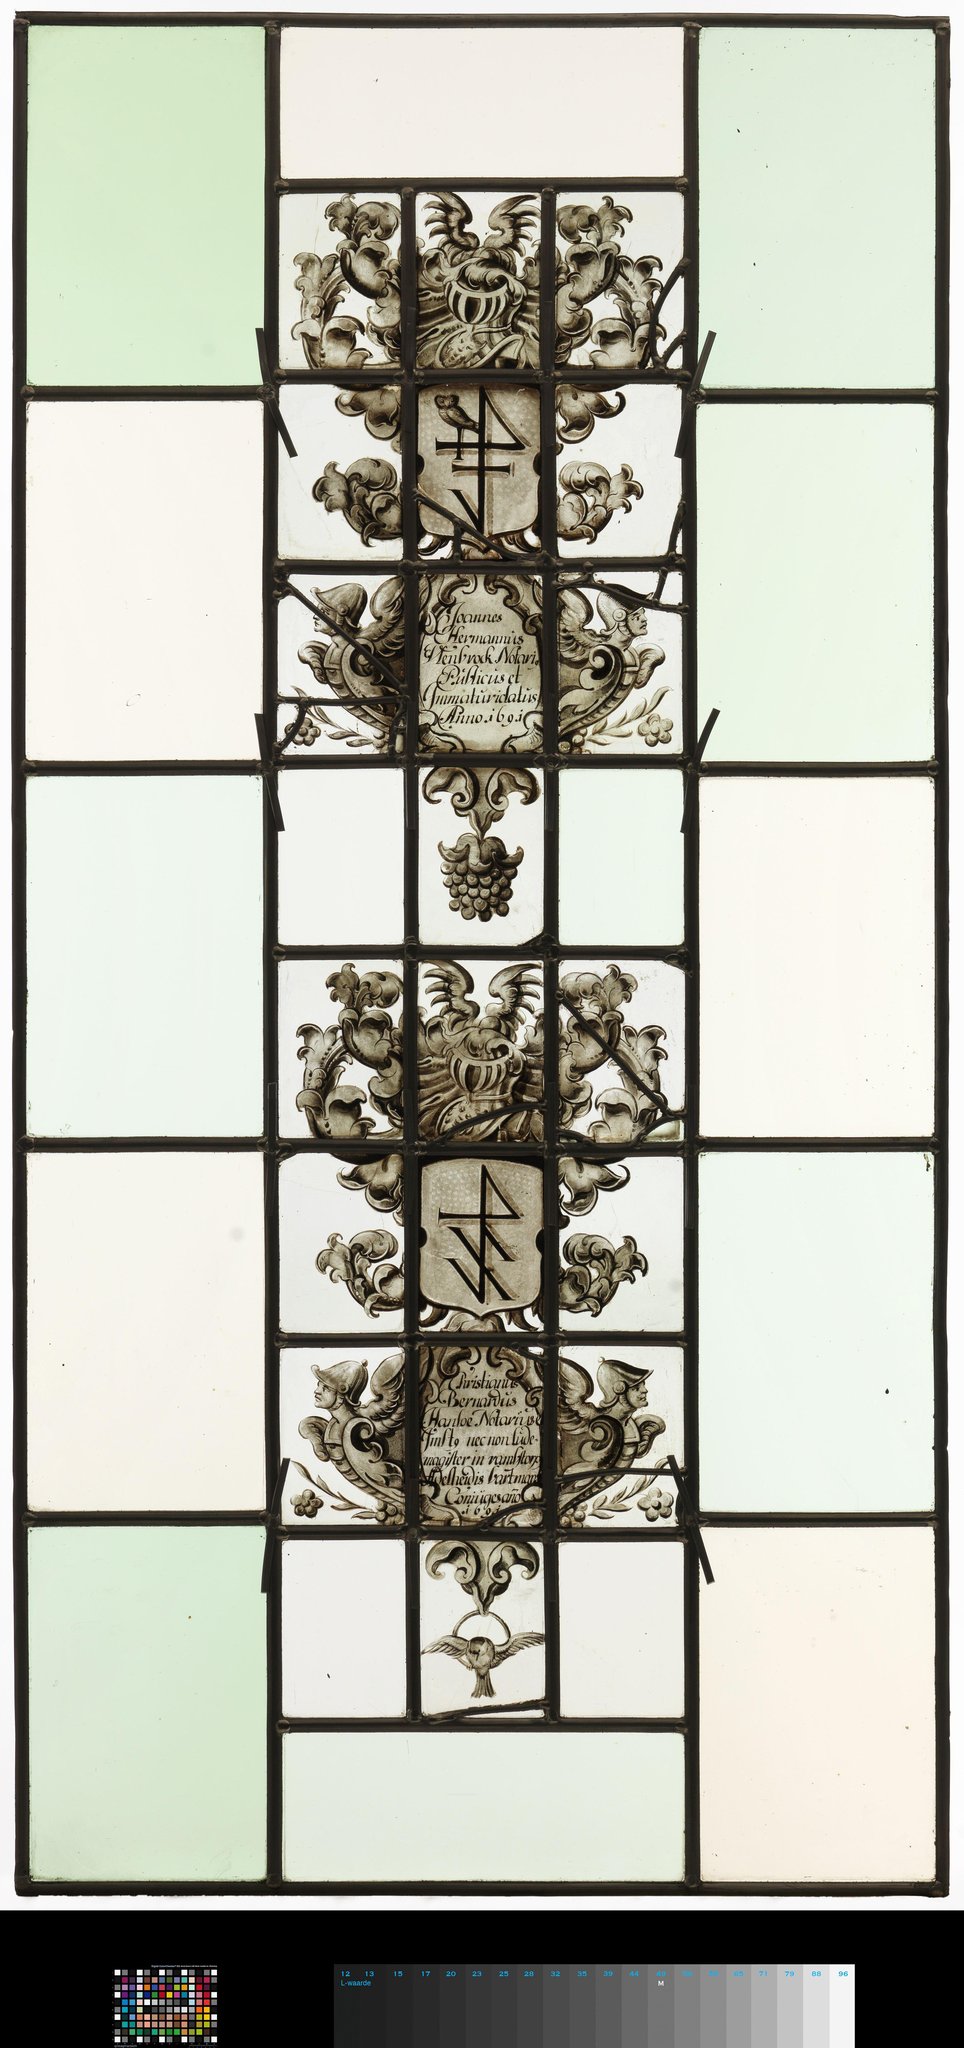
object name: light window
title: Ruit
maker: Anonymous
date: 1699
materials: glass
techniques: enamel painting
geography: westphalia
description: Ruit met gebrandschilderde voorstelling, zit vast aan BK-2000-10-J.